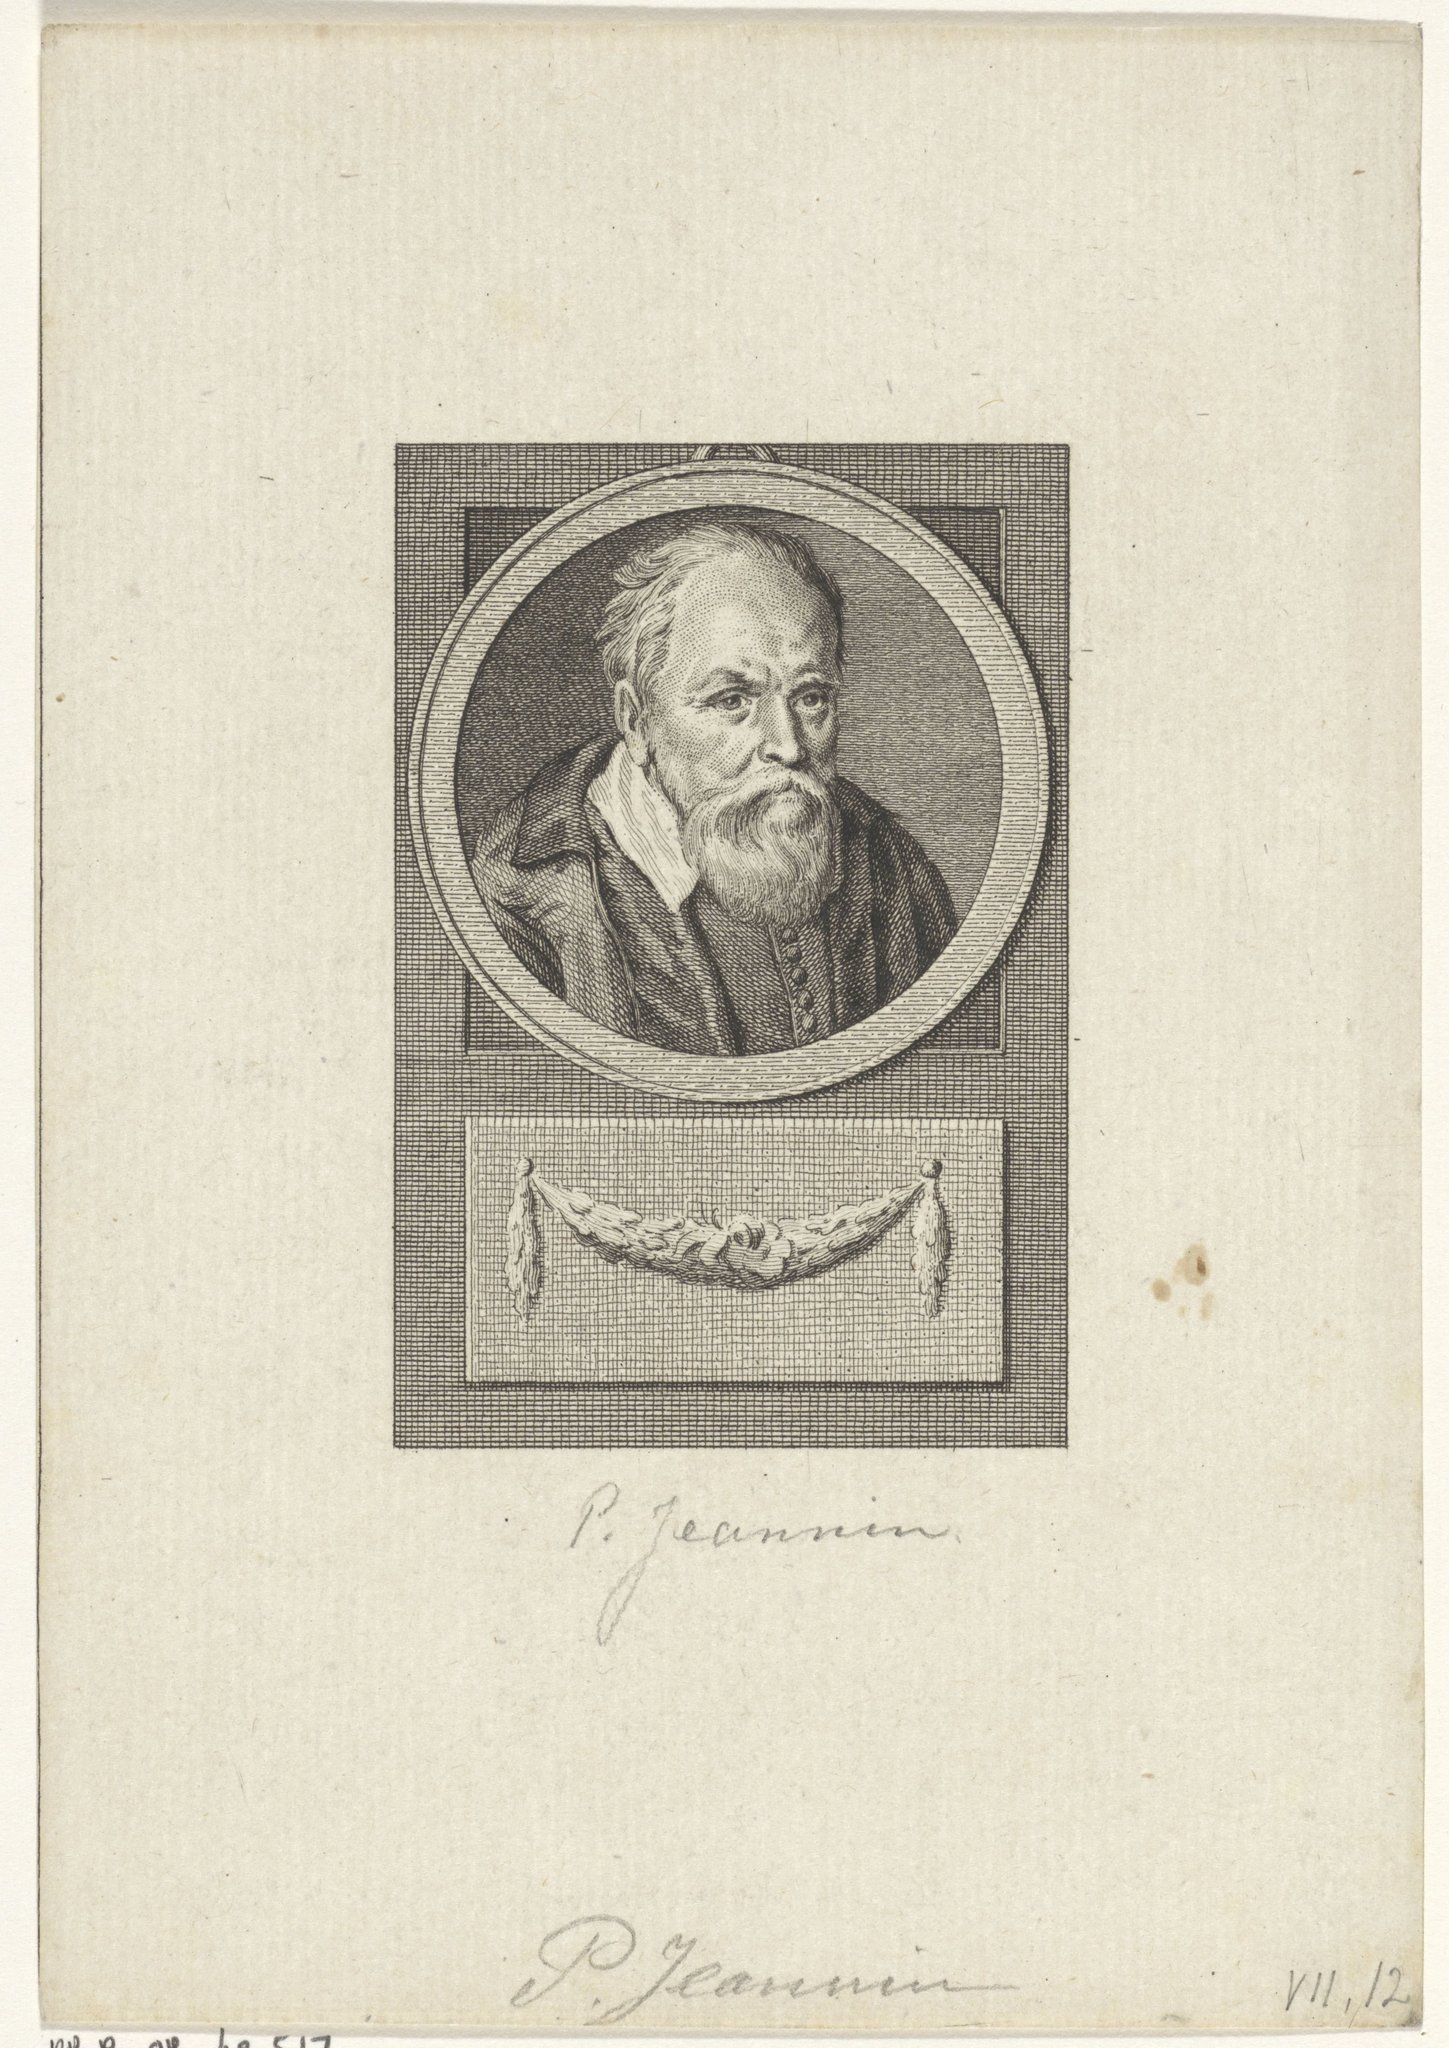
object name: print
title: Portret van Pierre Jeannin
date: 1783-1795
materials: paper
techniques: engraving, etching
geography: amsterdam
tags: paris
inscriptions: collector's mark: Lugt 2228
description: Latere staat prent gebruikt in: Fokke, Jan. Geschiedenissen der Vereenigde Nederlanden voor de vaderlandsche jeugd Ie-XXVste deel. Amsterdam: Johannes Allart, 1783-1795. Deel VII.